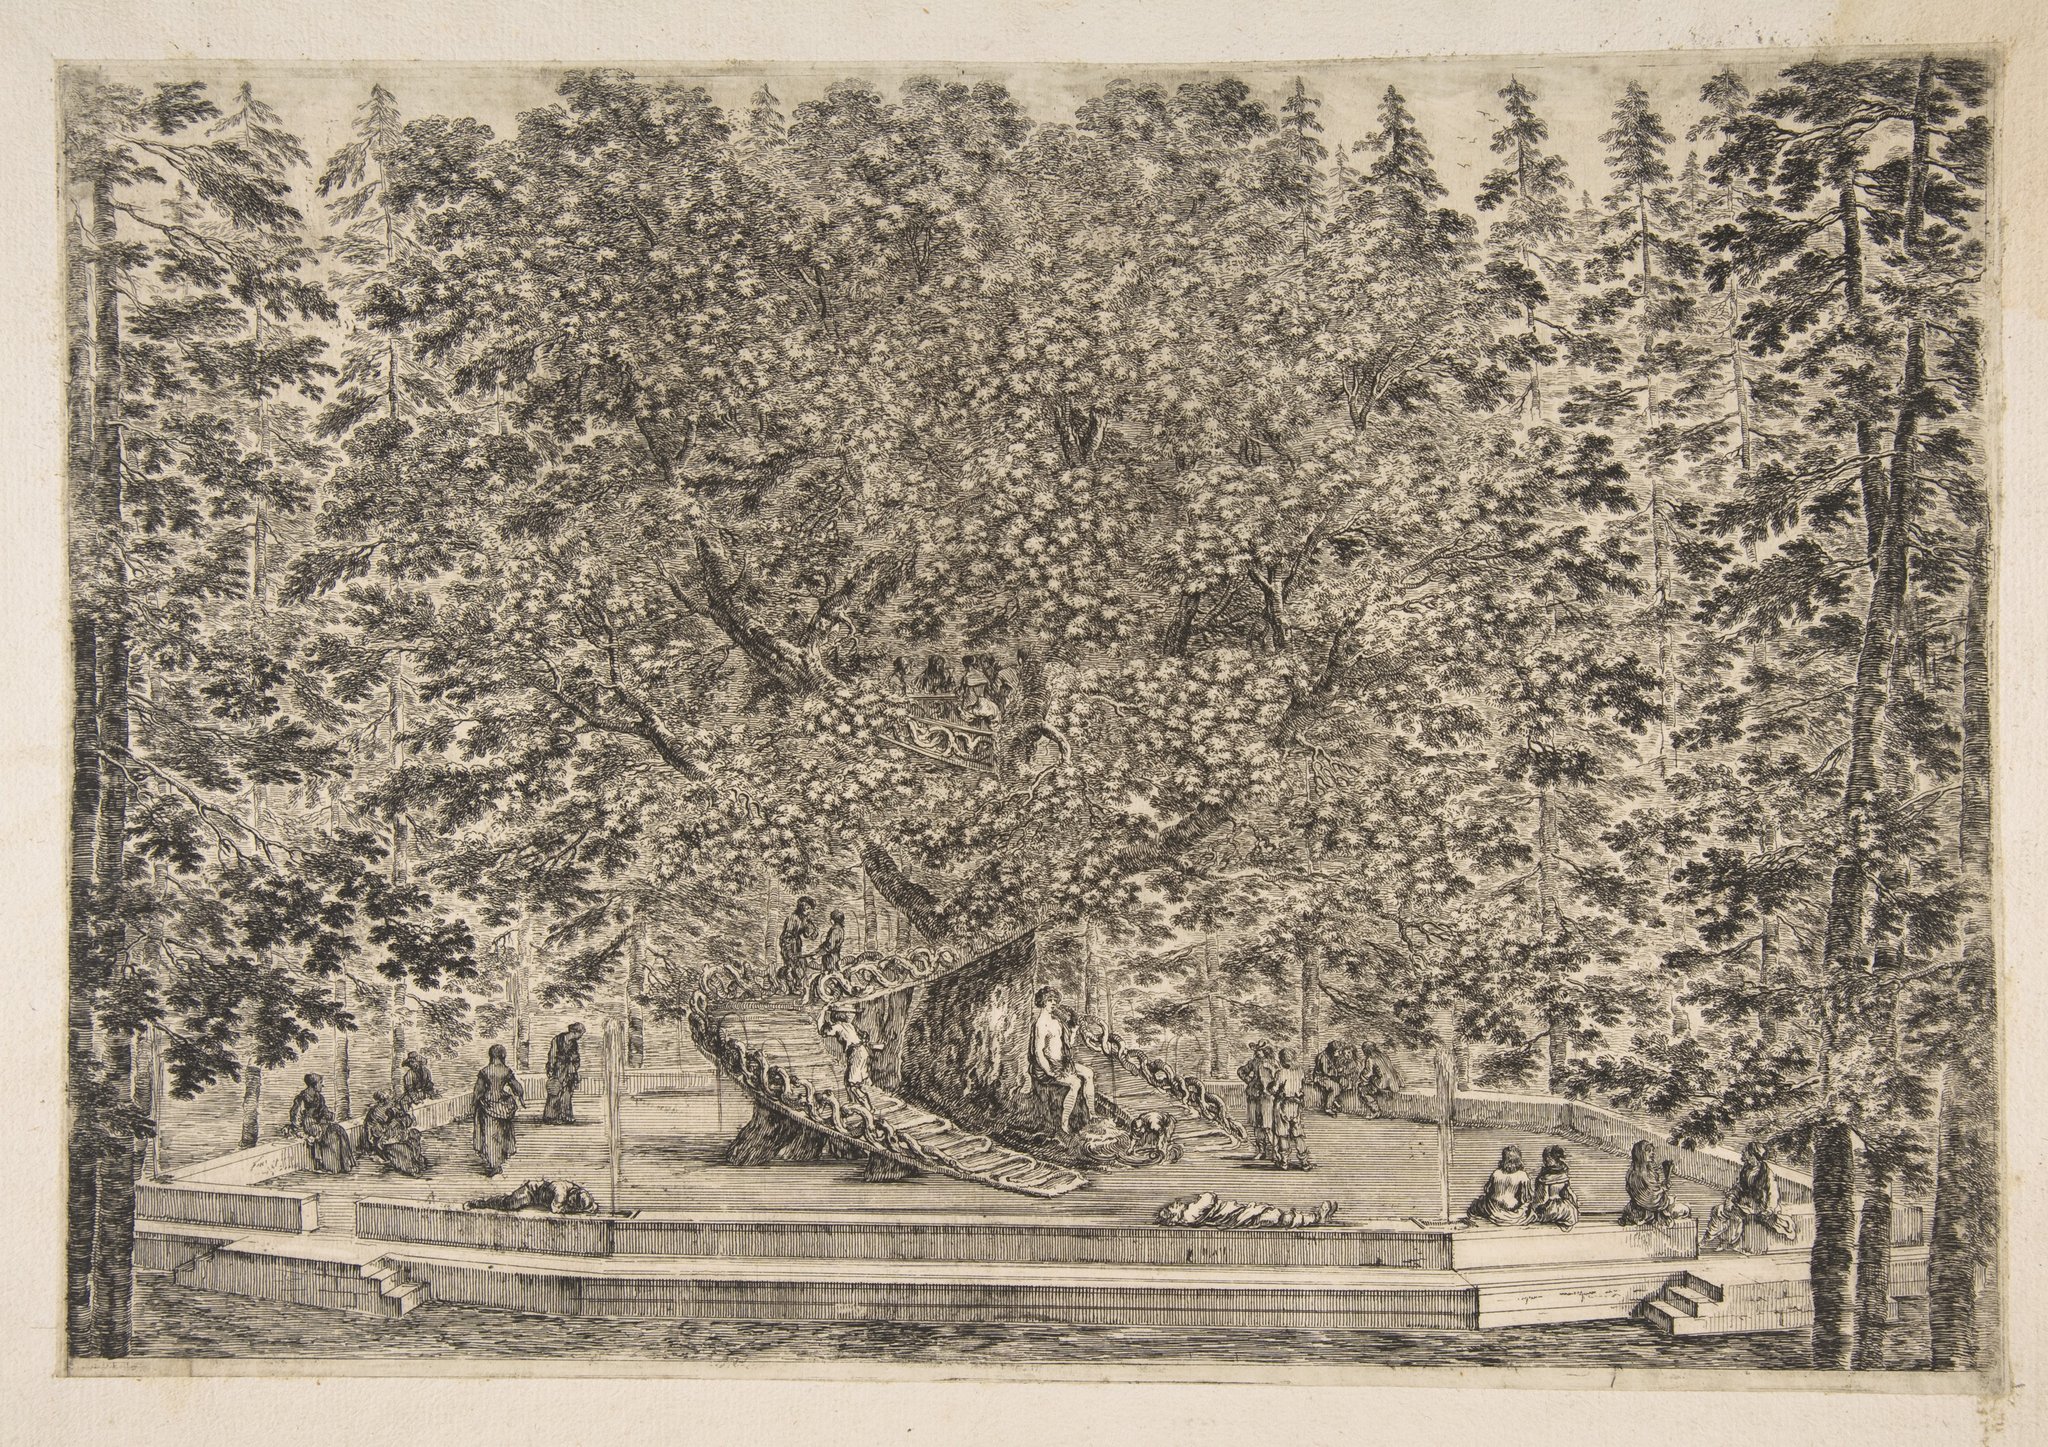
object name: print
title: The Tree House at Pratolino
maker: stefano della bella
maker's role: artist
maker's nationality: italian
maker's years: 1610-1664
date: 1653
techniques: etching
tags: human figures,houses,trees